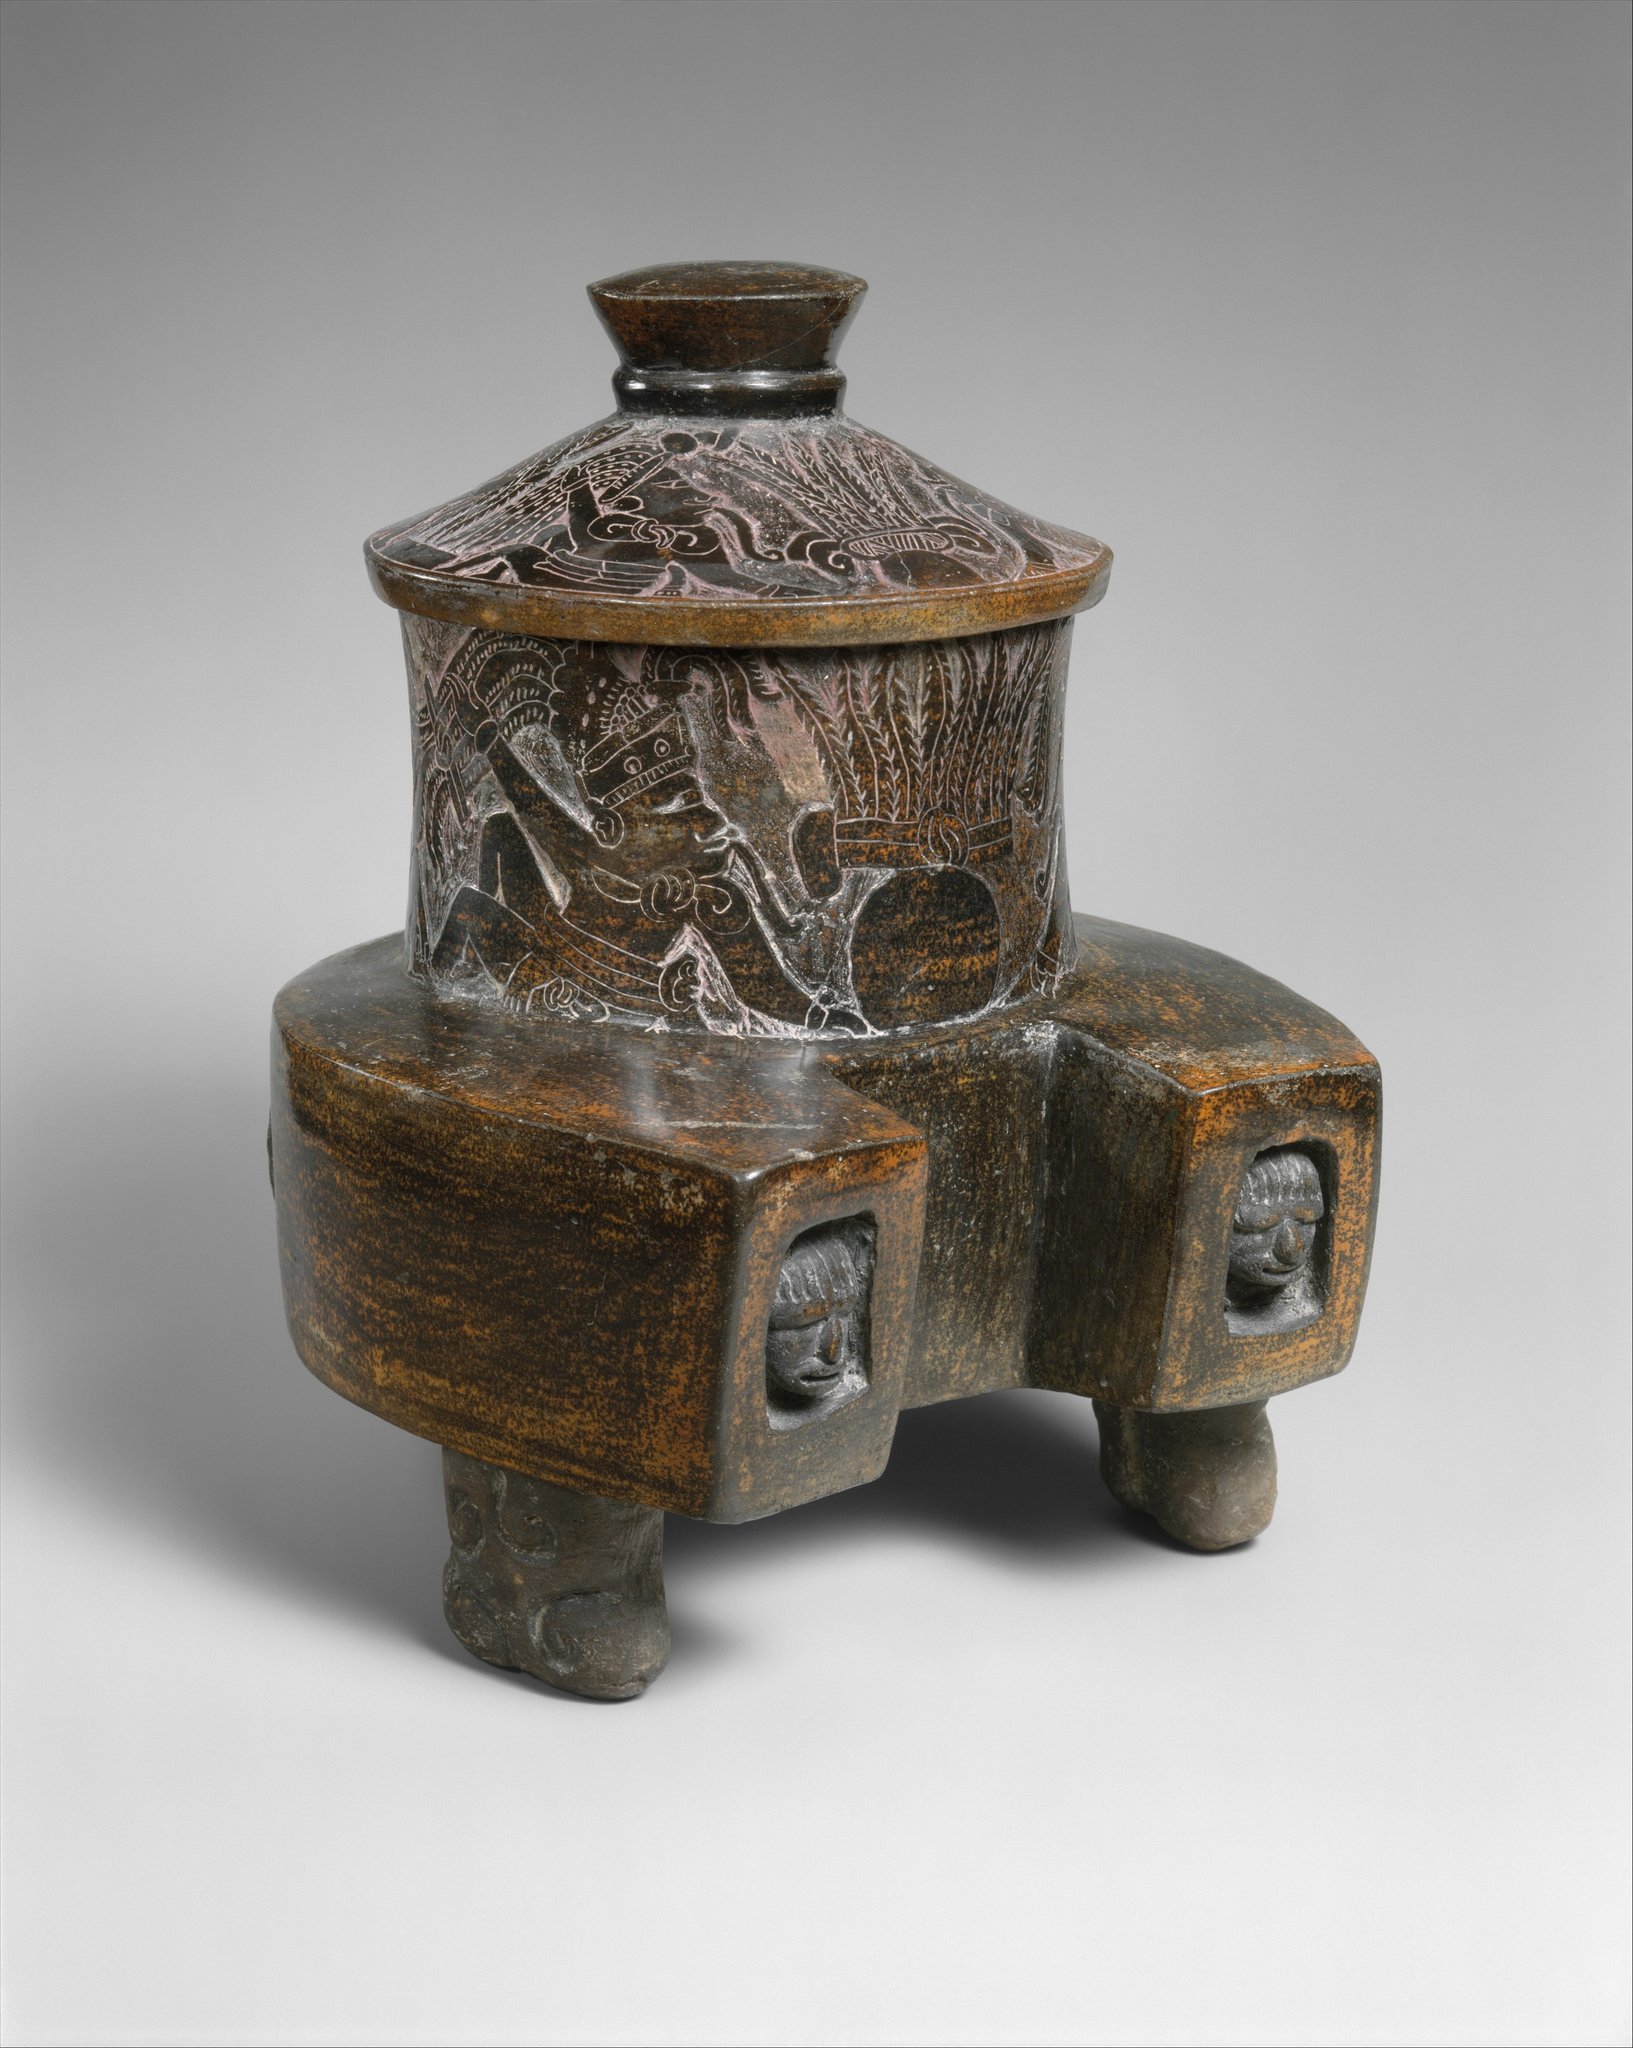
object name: vessel with lid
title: Yoke-form vessel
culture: maya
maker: maya artist(s)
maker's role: artist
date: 350-450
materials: ceramic, pigment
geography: guatemala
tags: faces,men